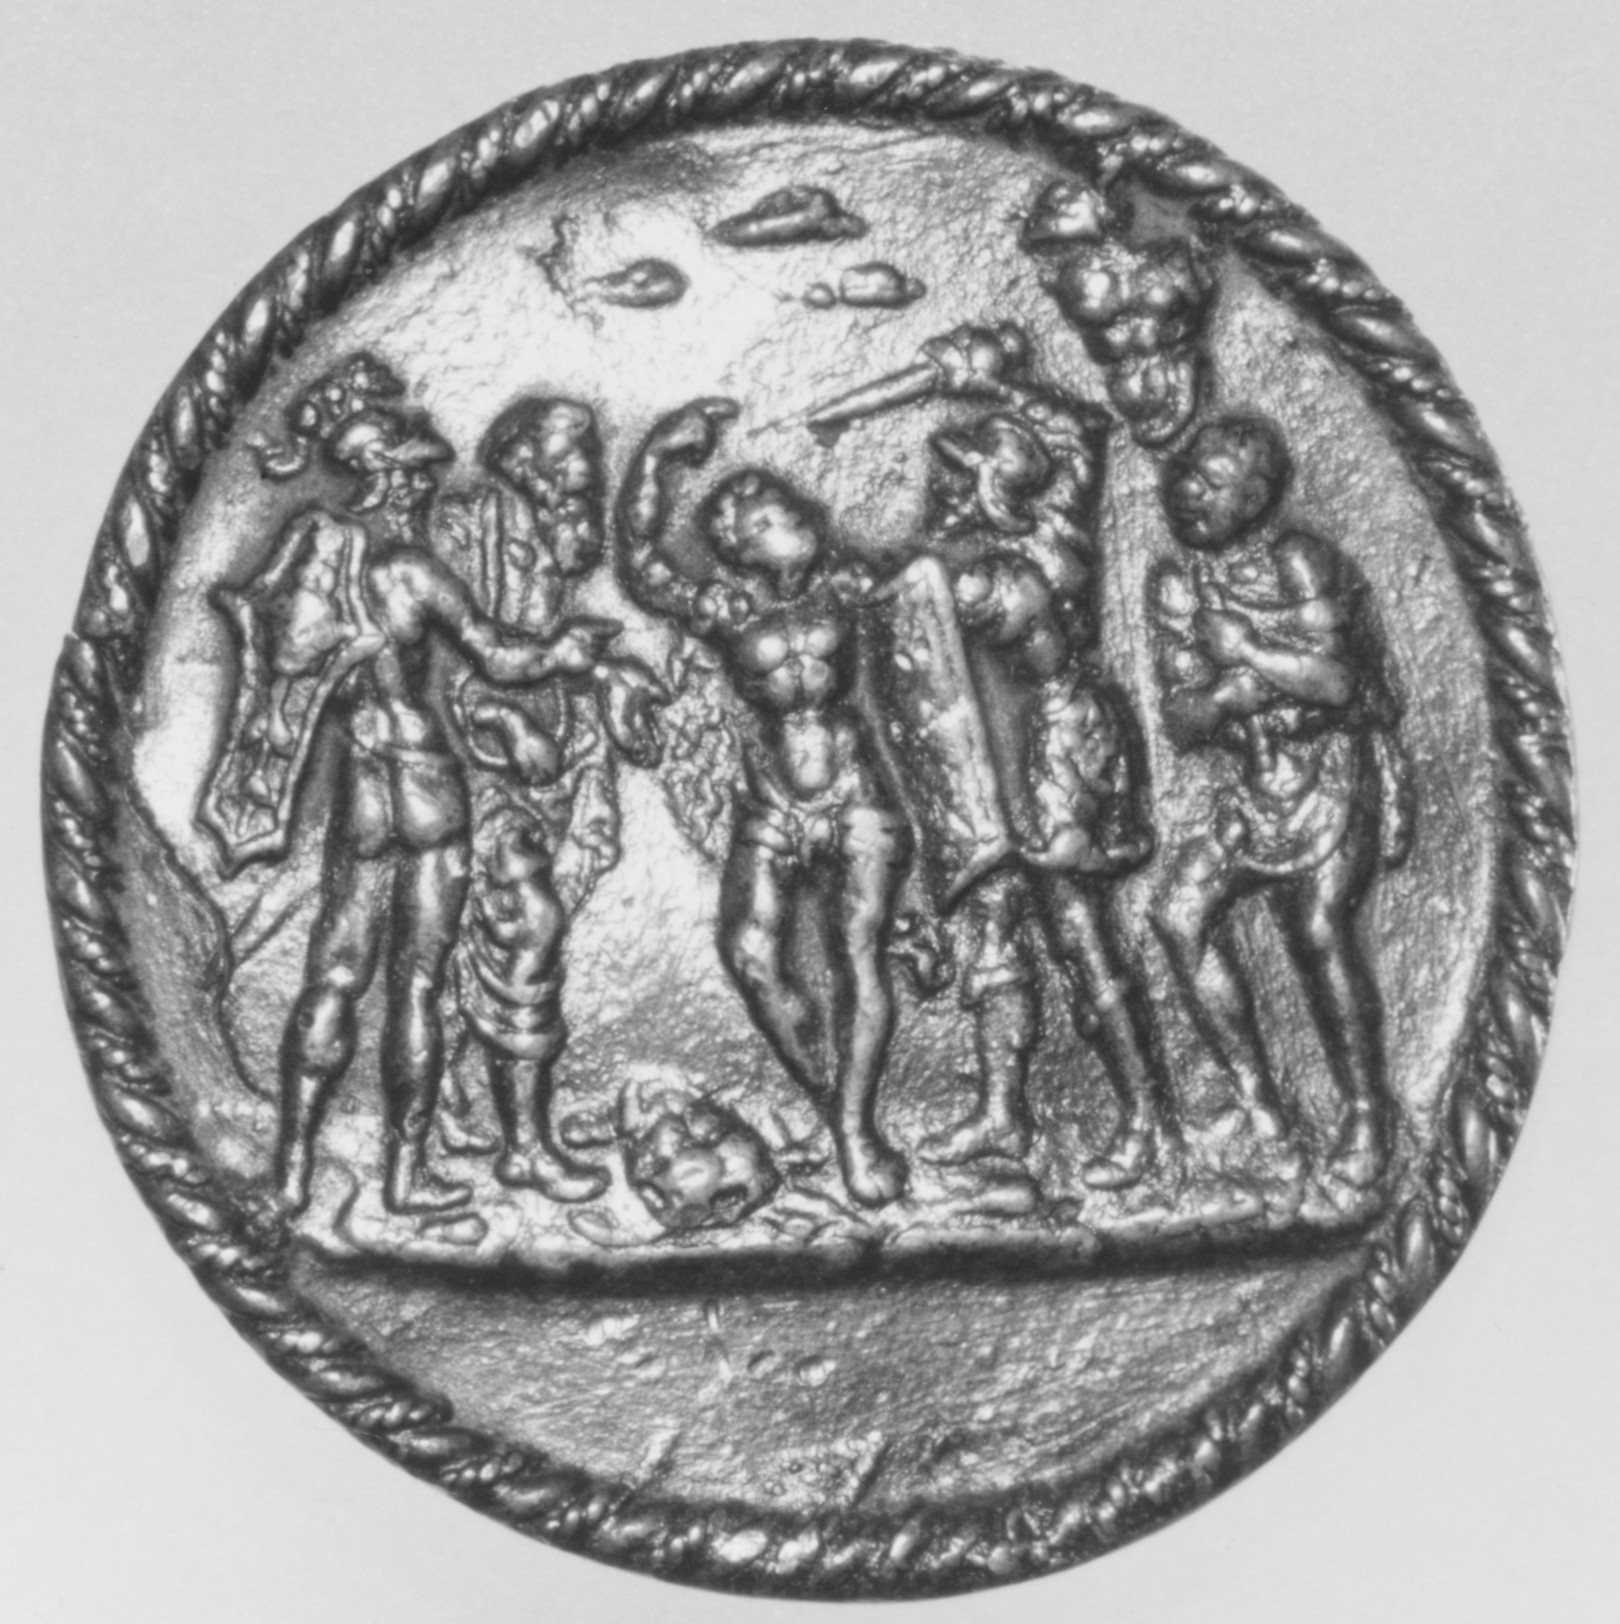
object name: plaquette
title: Sacrifice of Iphigenia (?)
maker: master io. f.f.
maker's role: artist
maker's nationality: italian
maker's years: 1400-1550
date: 1501-1533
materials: bronze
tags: human figures,iphigenia